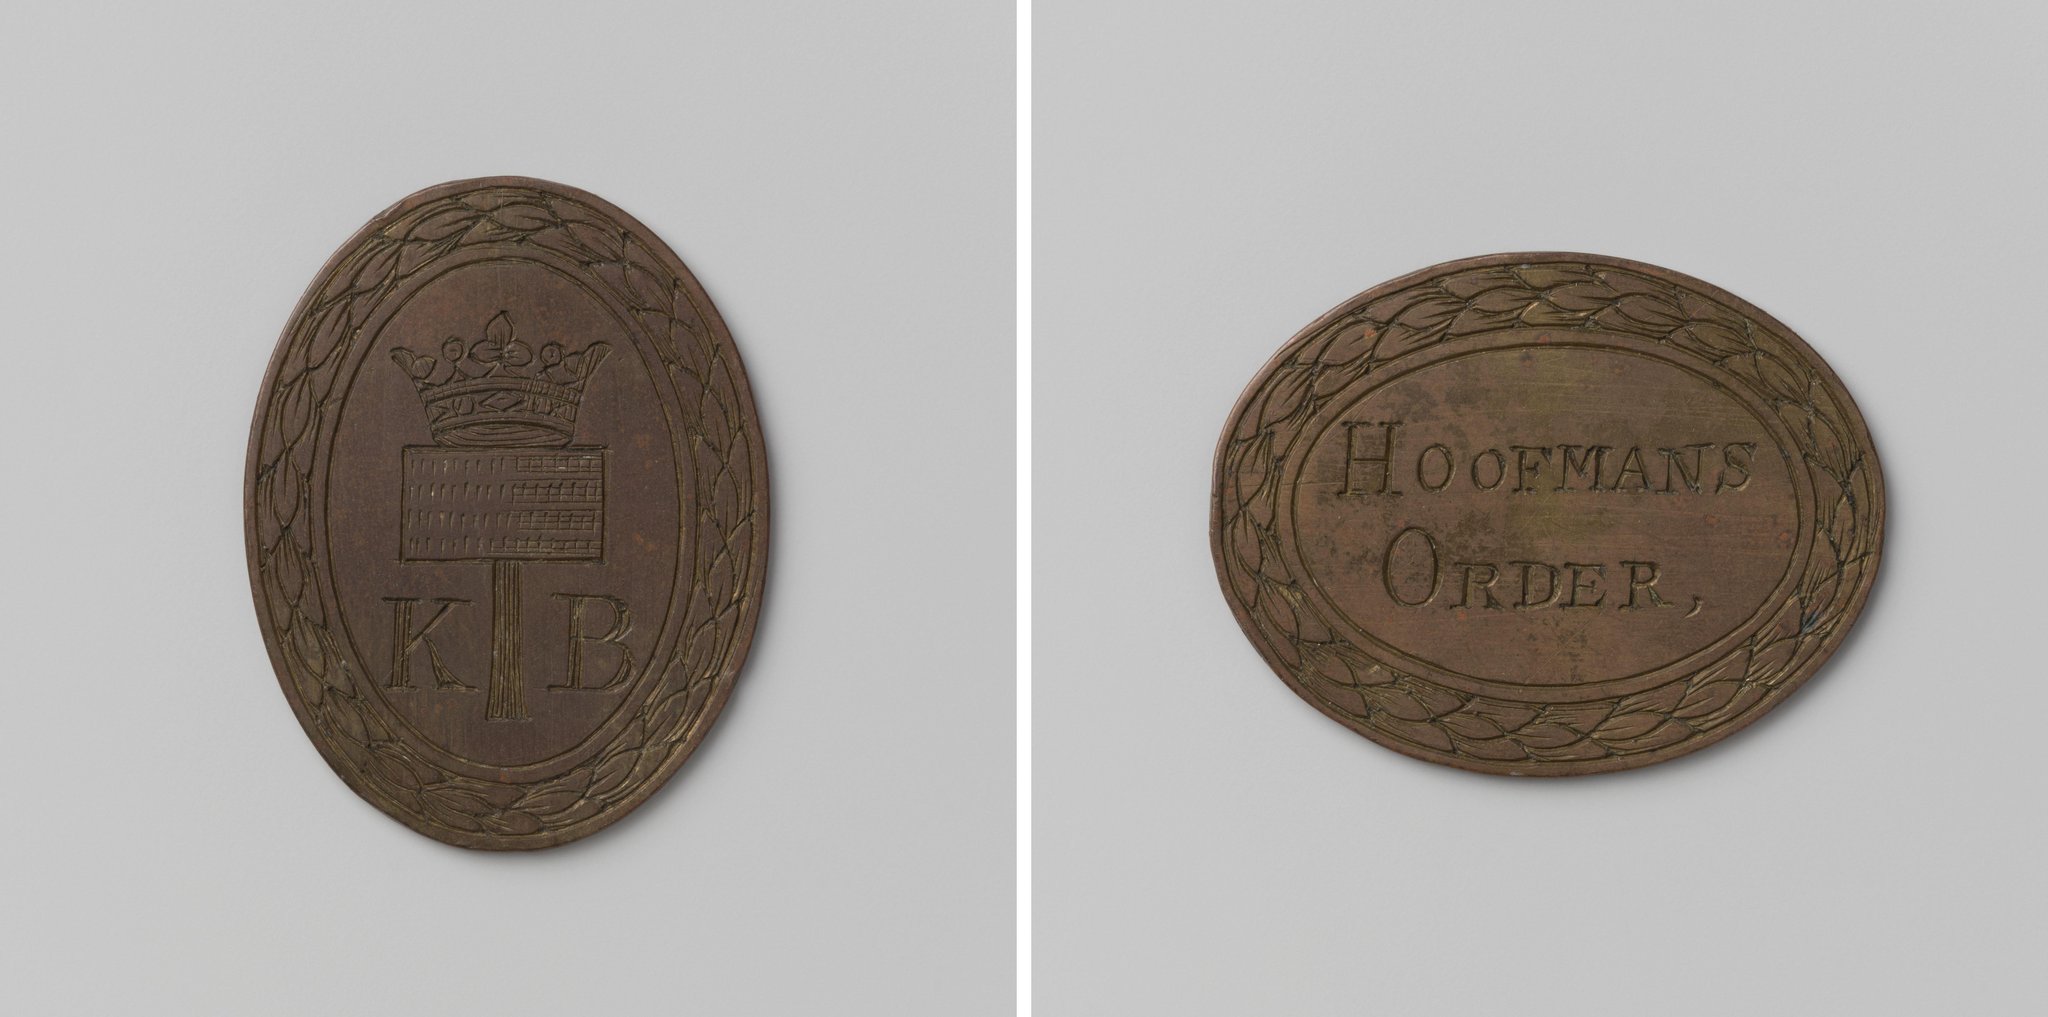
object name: medal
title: Onbekend gilde, gildepenning met opschrift Hoofmans Order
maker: Anonymous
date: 1600-1700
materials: brass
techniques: engraving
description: Messing ovale penning. Voorzijde: gekroonde hamer tussen letters K en B binnen bladerkrans. Keerzijde: opschrift binnen bladerkrans, vermoedelijk een gildepenning.